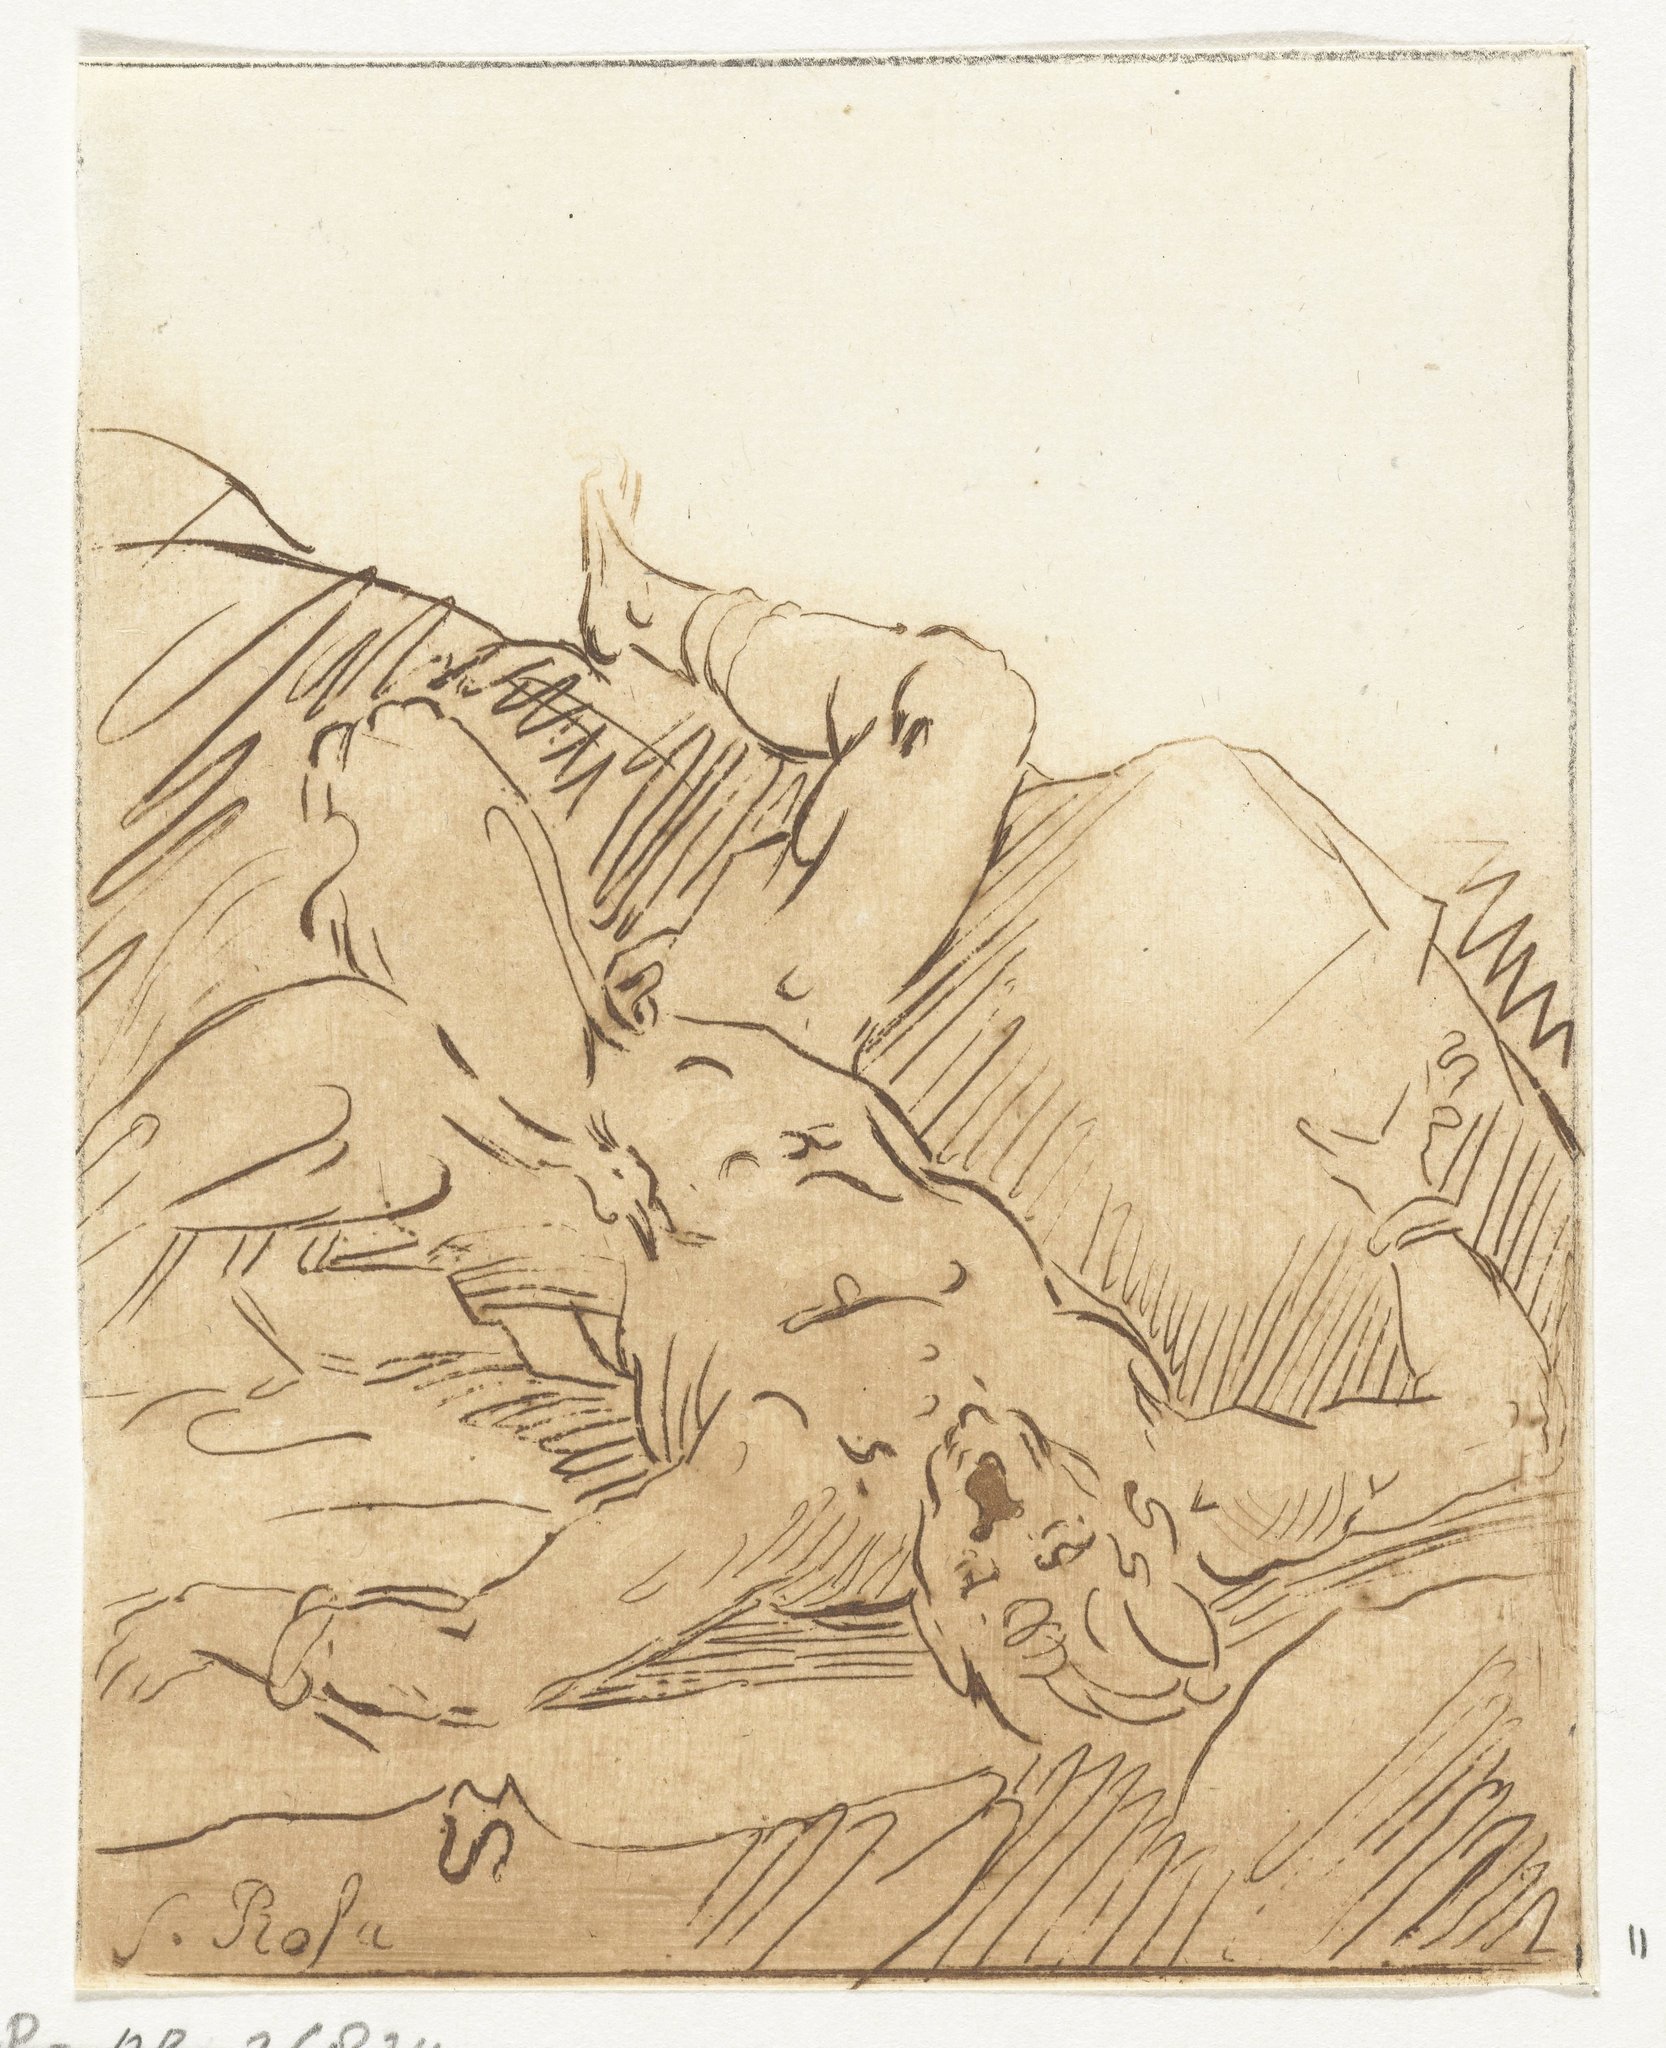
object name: print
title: Prometheus geketend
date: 1778-1838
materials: paper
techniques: aquatint, etching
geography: netherlands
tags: an eagle tears at prometheus' liver, (story of) prometheus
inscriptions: collector's mark: Lugt 2228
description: Prometheus is vastgeketend aan een rots en een adelaar pikt zijn lever uit. Prometheus kreeg deze straf van Jupiter opgelegd omdat hij de Goden het vuur stal en het aan de mensen gaf.